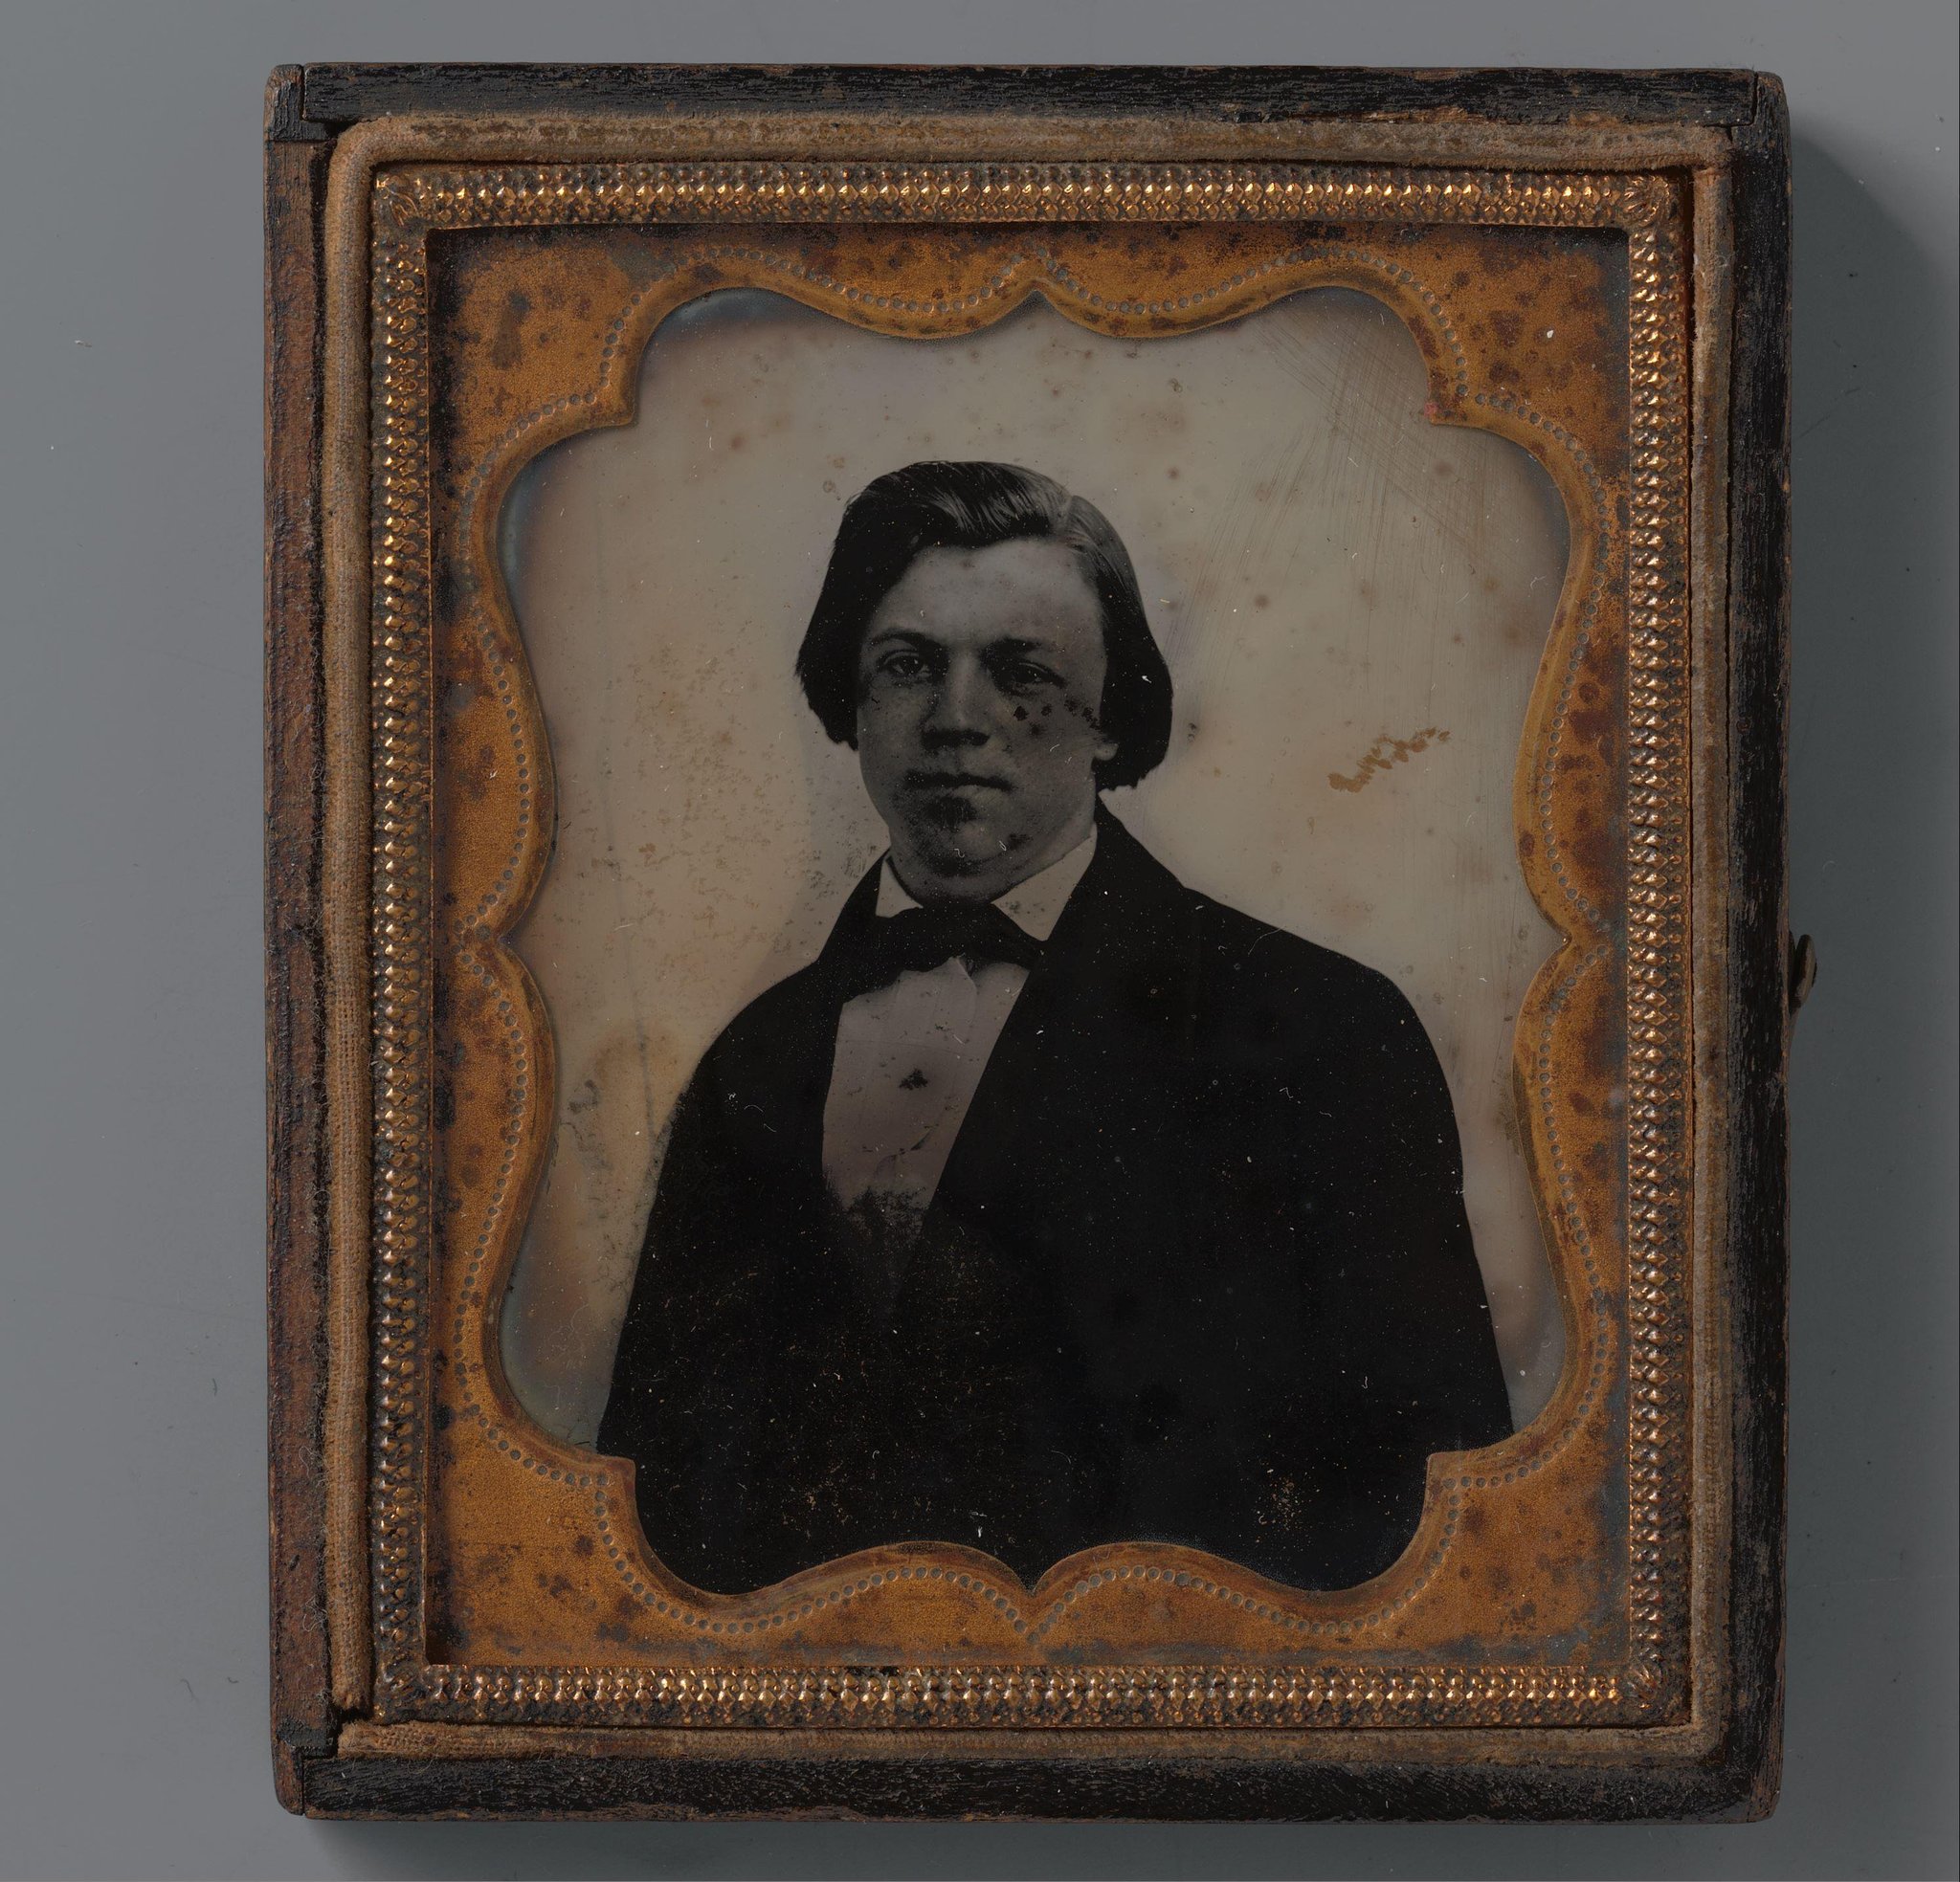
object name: photograph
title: Portret van een onbekende jongeman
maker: Anonymous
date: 1855-1870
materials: glass, metal, velvet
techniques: ambrotype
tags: historical persons, youth, adolescent